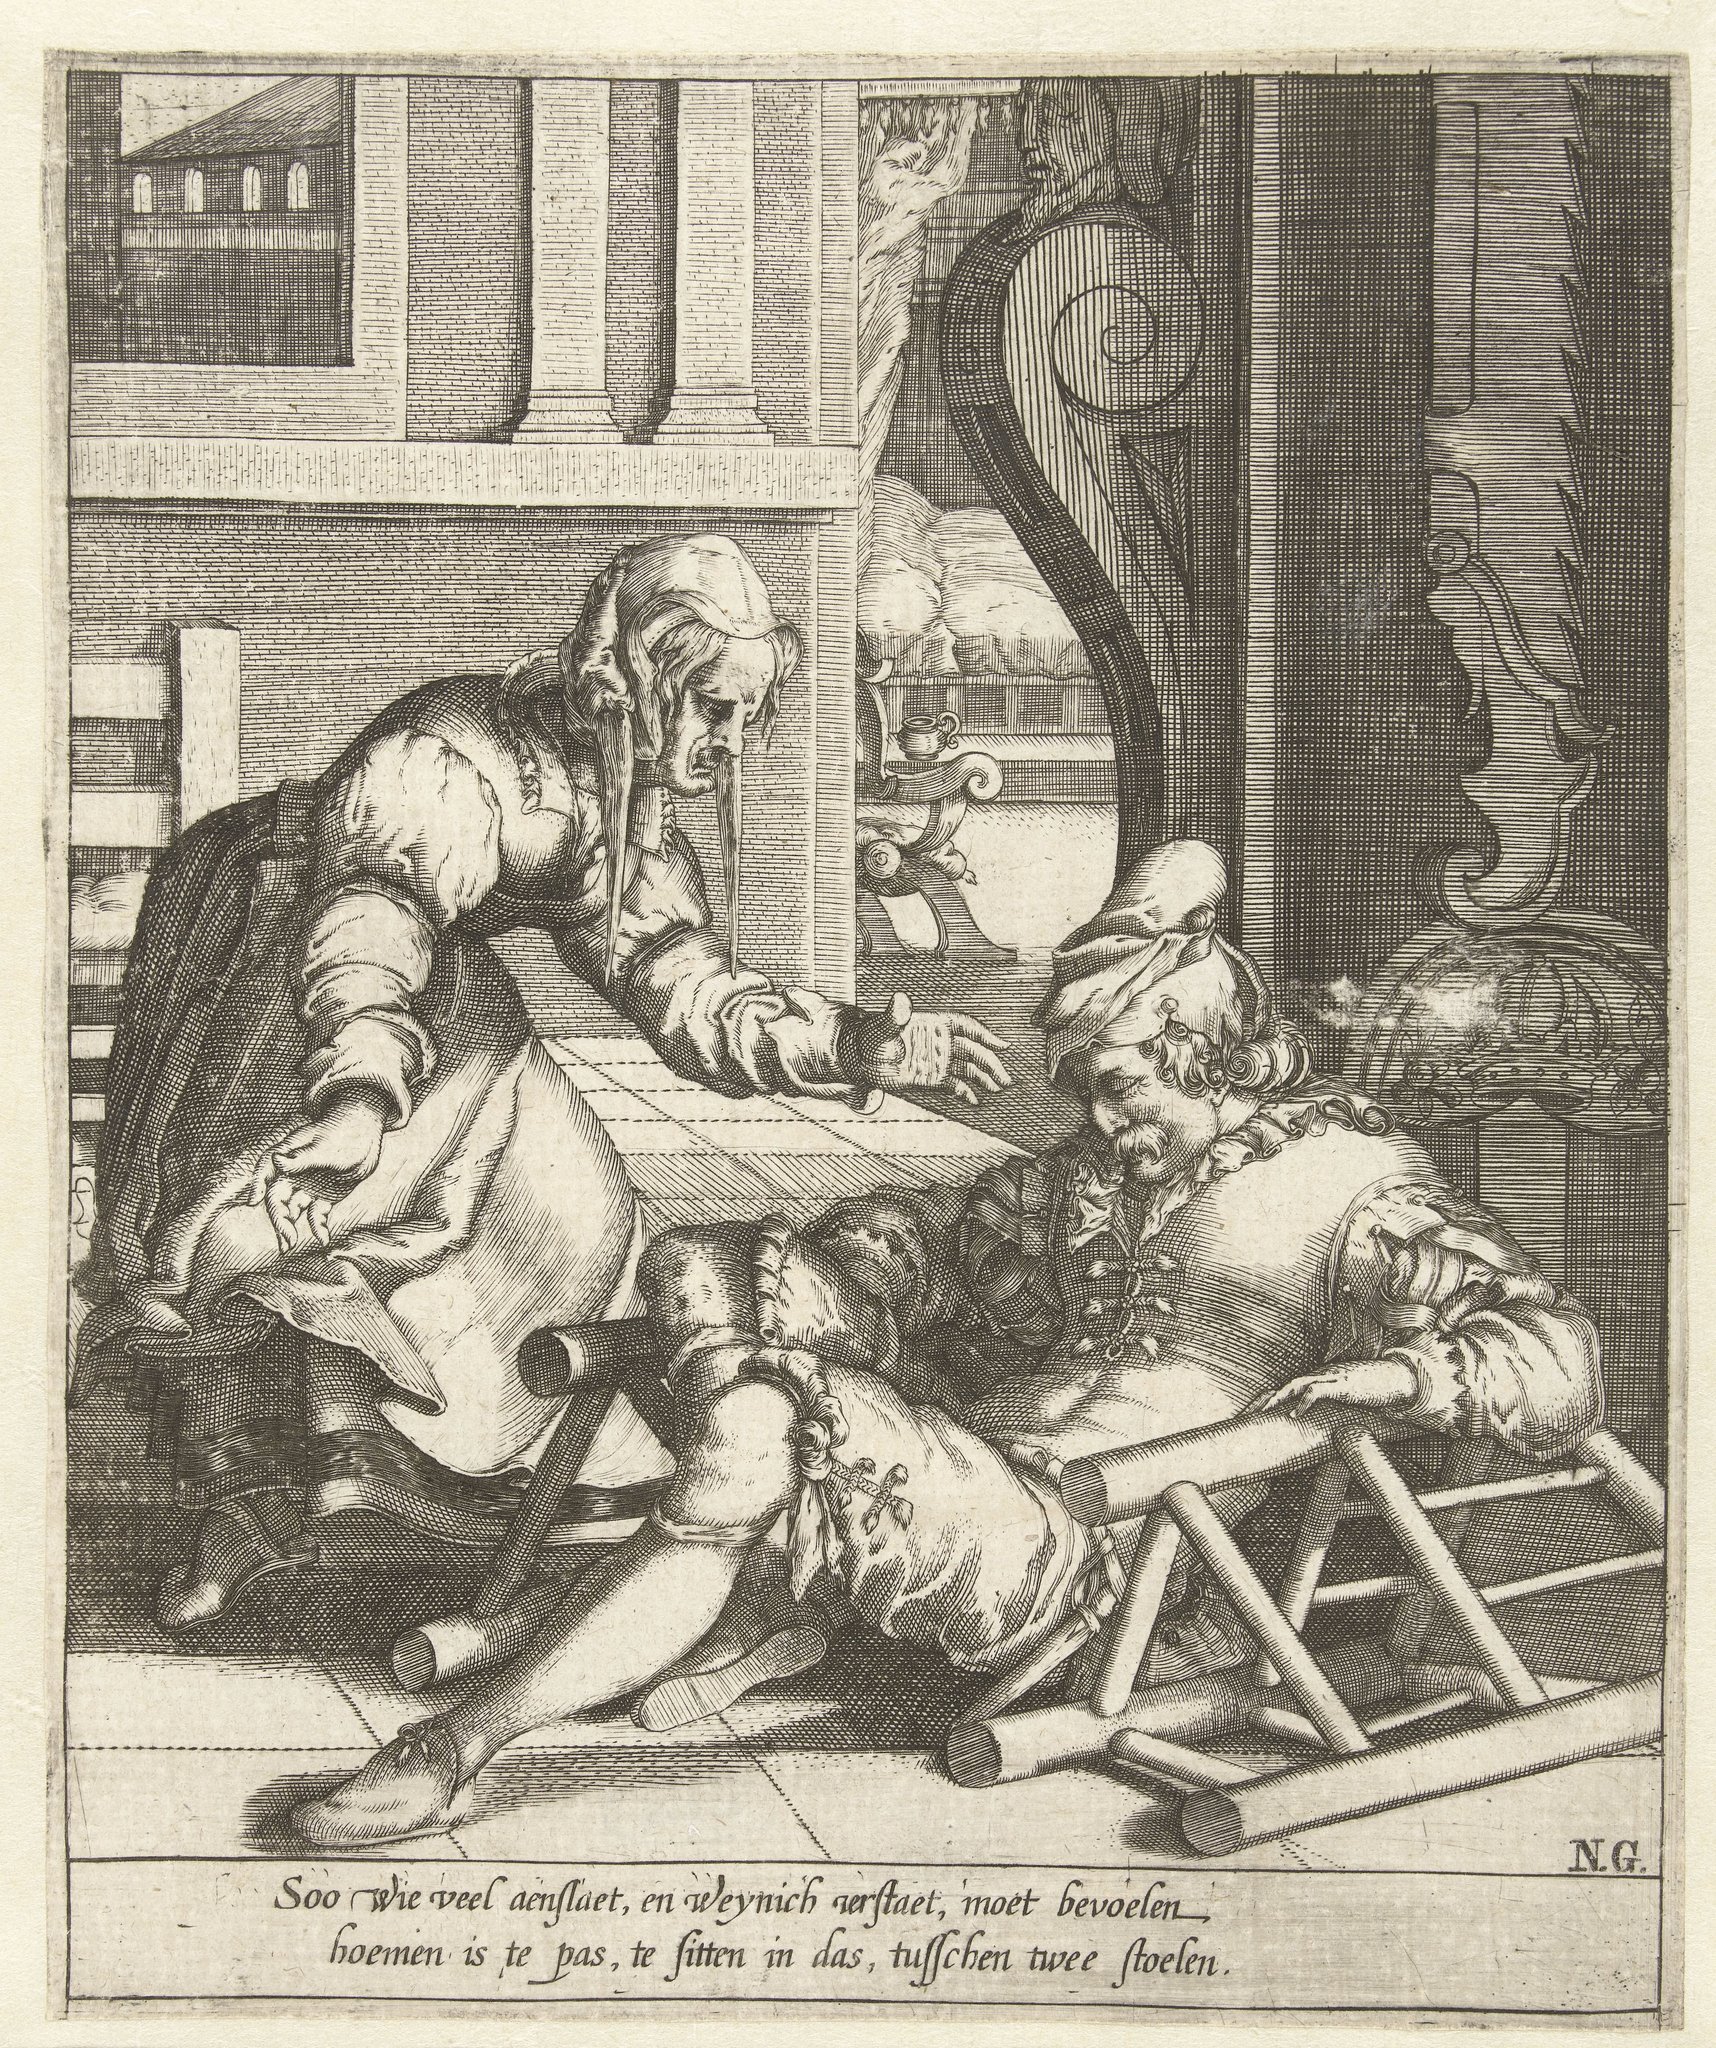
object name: print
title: Man valt tussen twee stoelen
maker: gillis van breen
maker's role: print maker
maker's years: 1550-1622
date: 1595-1610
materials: paper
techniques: engraving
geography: netherlands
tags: proverbs, sayings, etc., chair, the (difficult) choice ~ courting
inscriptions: inscription: ‘Soo wie veel aenslaet, en weynich verstaet, moet bevoelen / hoe men is te pas, te sitten in das, tusschen twee stoelen.’, collector's mark: Lugt 2228, collector's mark: Lugt 1967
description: Een man valt tussen twee stoelen. Zijn vrouw probeert hem weer op te helpen. Verbeelding van het spreekwoord "tussen twee stoelen in de as zitten", over het niet kunnen kiezen tussen twee mogelijkheden.